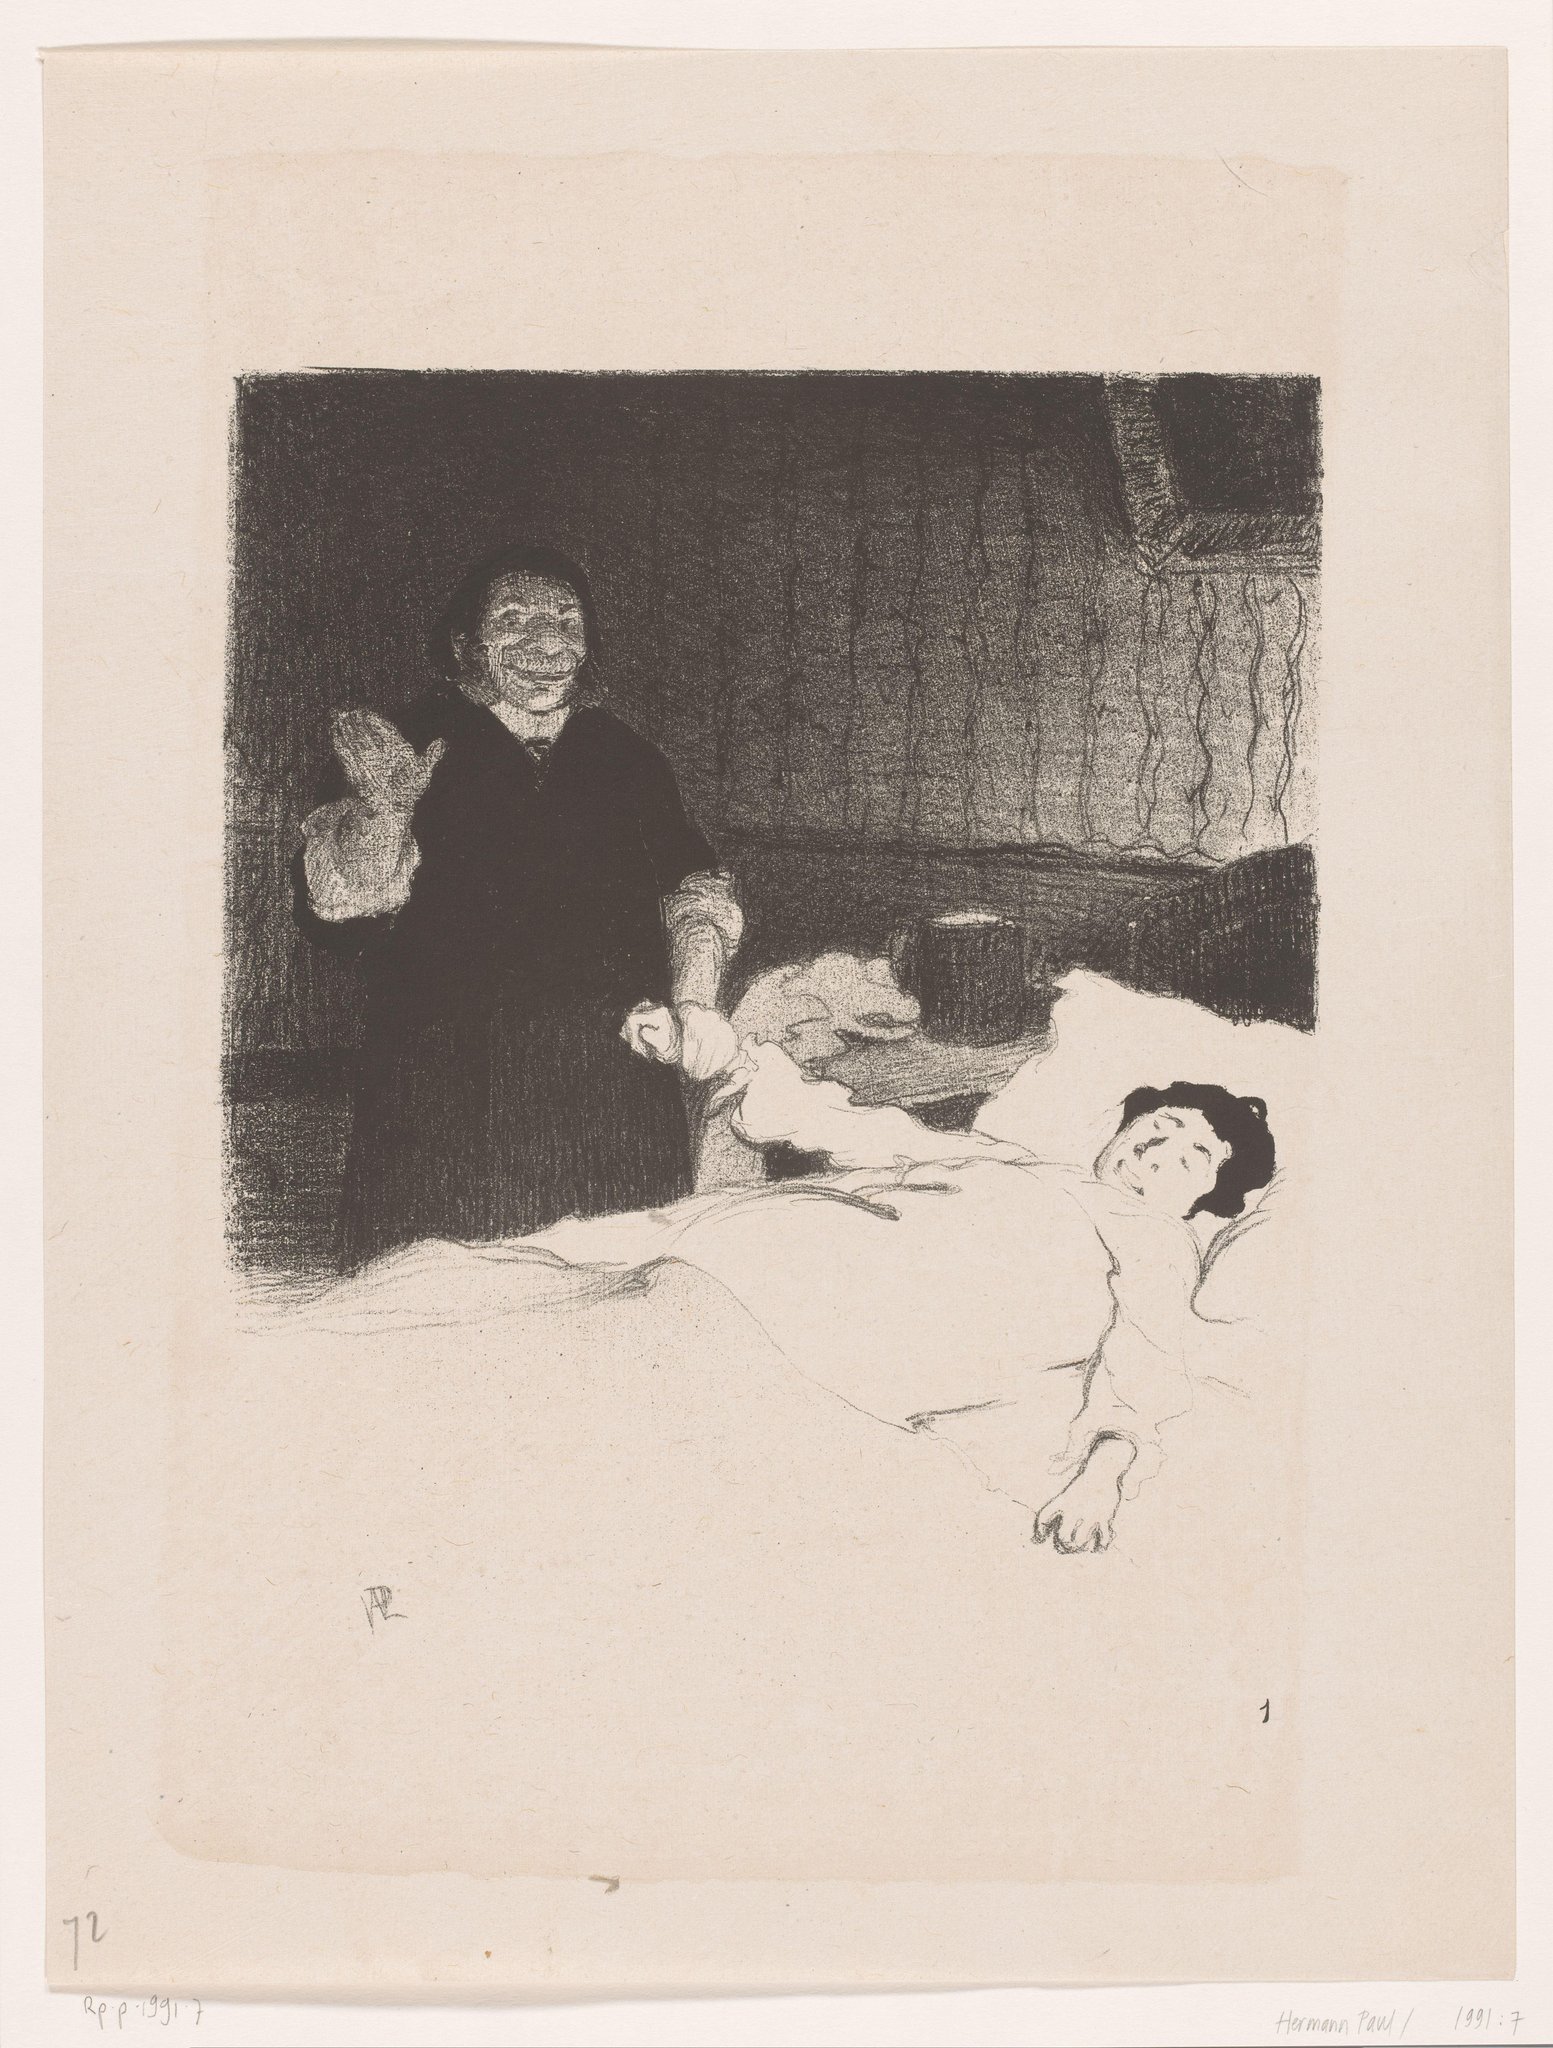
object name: print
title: Il nait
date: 1895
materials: paper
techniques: lithograph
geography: paris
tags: sleeping in bed